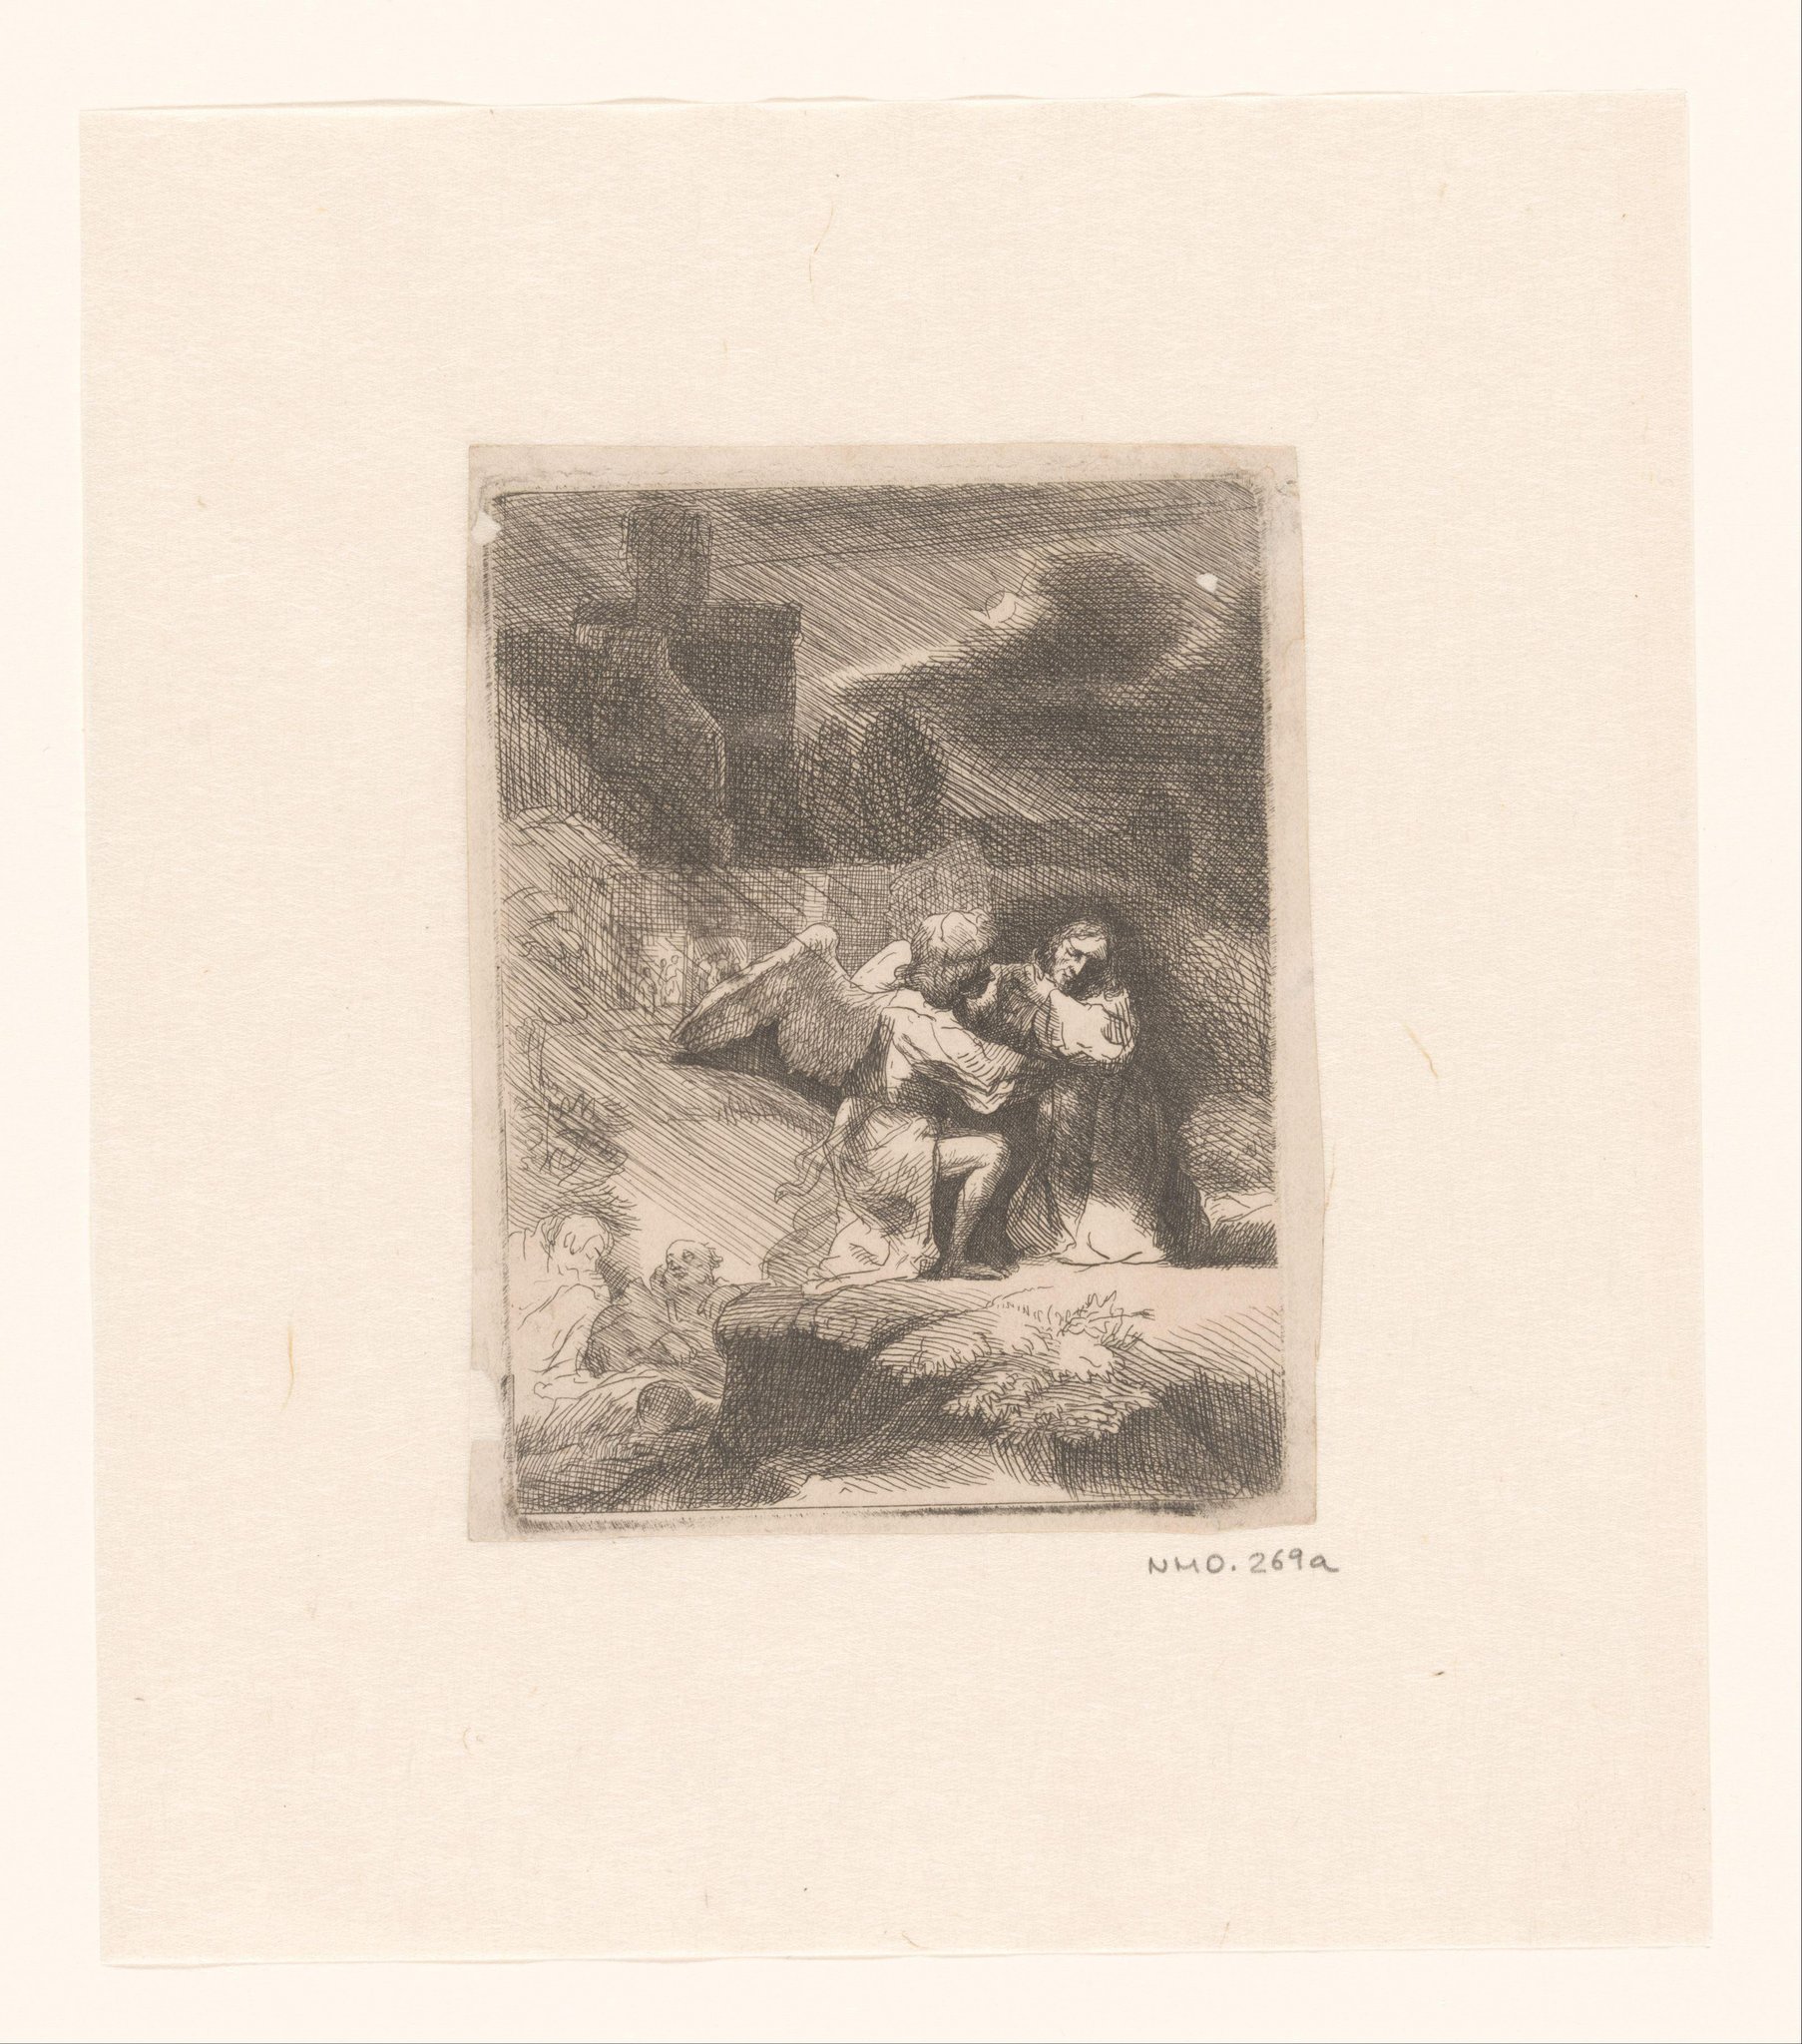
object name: print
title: The agony in the garden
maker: Anonymous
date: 1651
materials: paper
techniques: etching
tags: gethsemane, mount of olives, 'oelberg' (matthew 26:36-56; mark 14:32-52; luke 22:39-53; john 18:1-12)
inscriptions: collector's mark: Lugt 2760, collector's mark: Lugt 2228